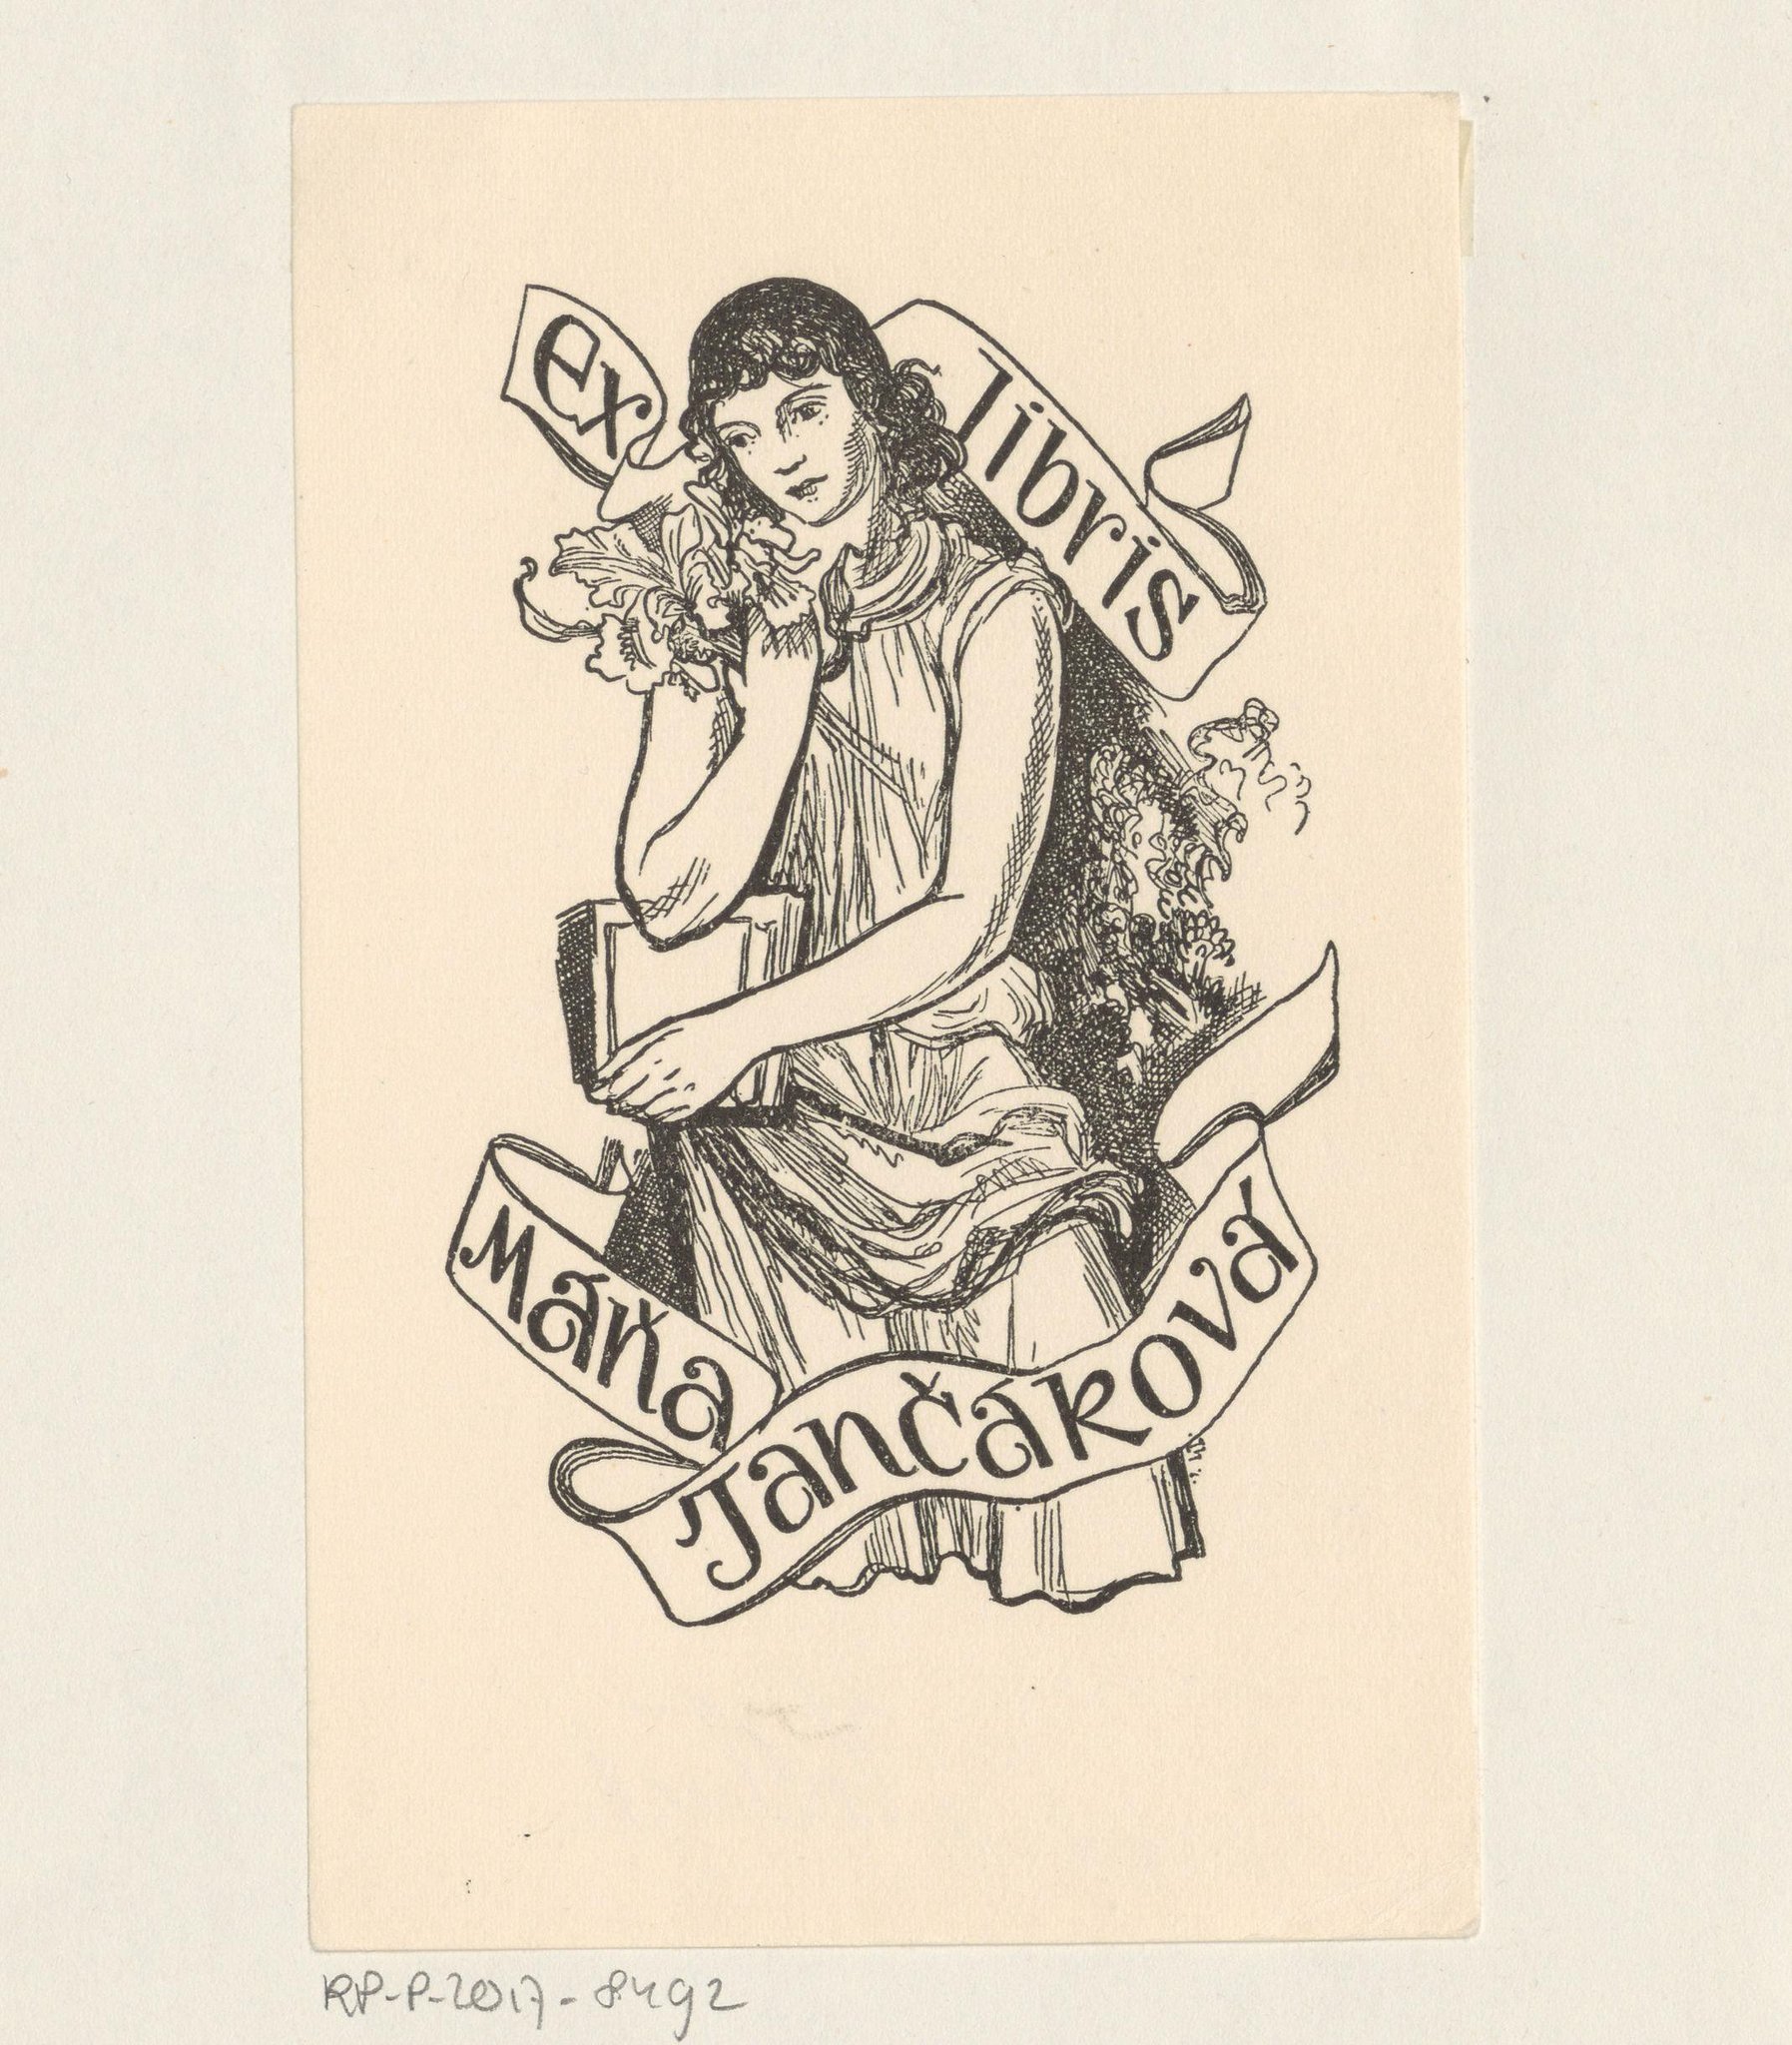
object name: bookplate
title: Ex libris van Máňa Jančáková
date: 1900-1999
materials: paper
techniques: printing block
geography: czech republic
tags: book, standing figure - aa - female human figure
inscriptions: inscription: ‘Vozlueki [?]’